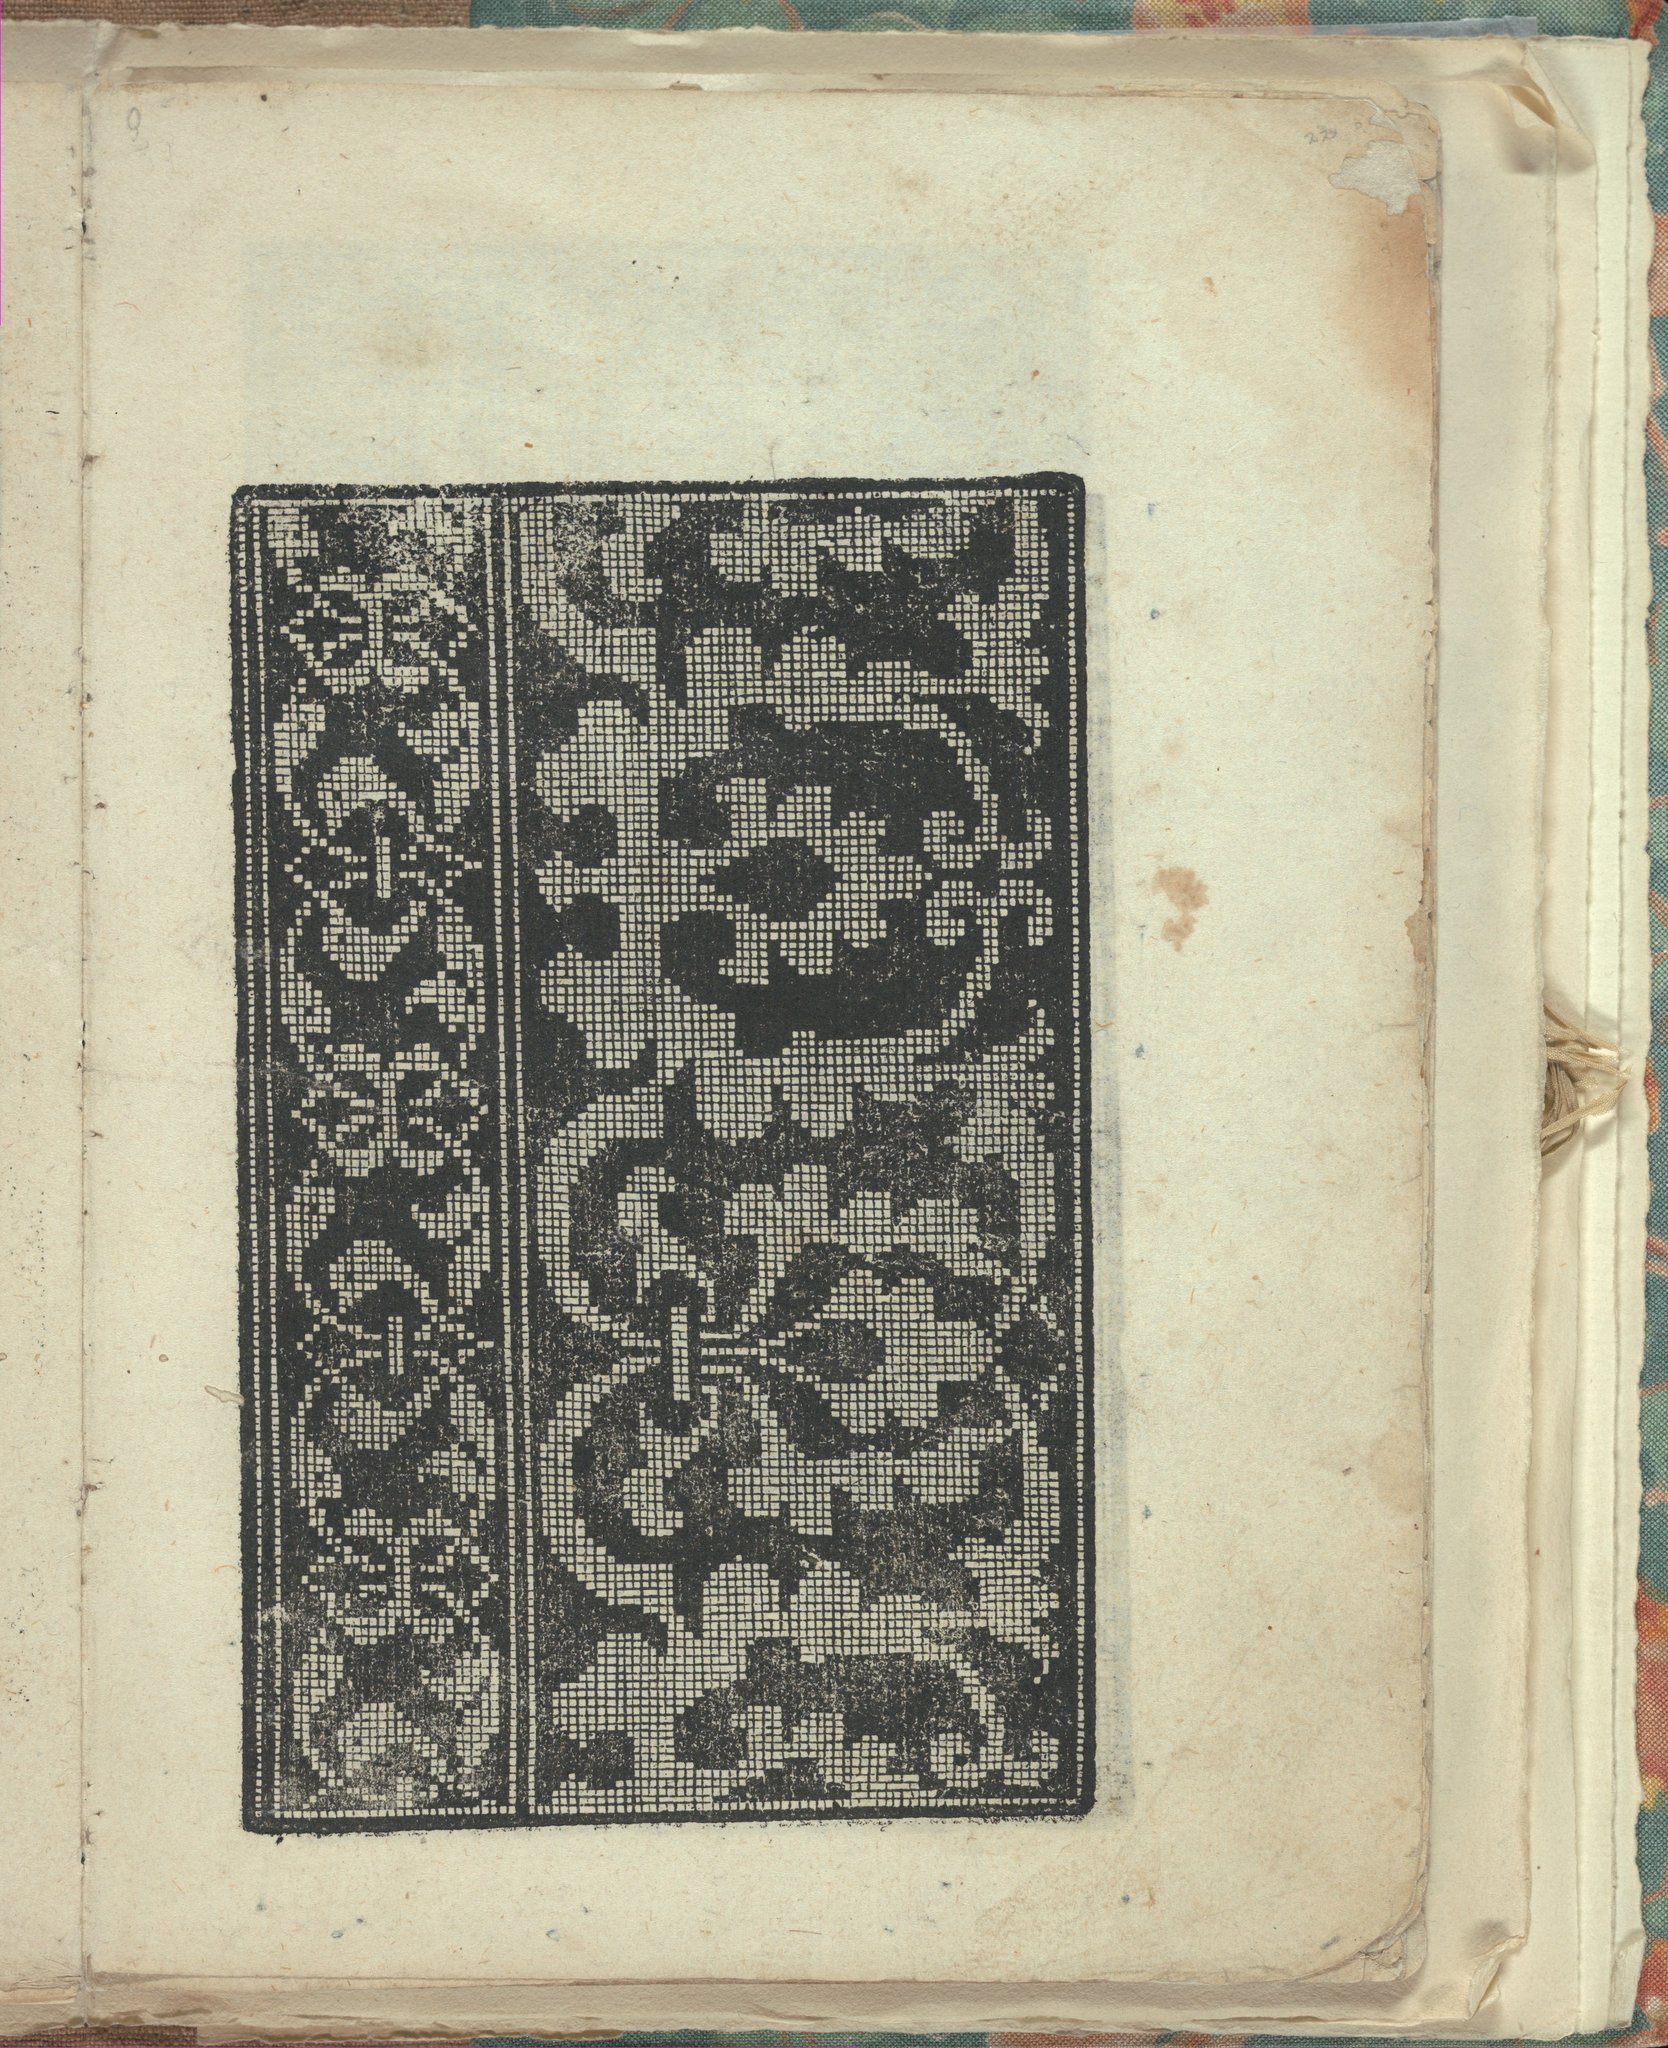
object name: book print ornament architecture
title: Opera Nova Universali intitulata Corona di racammi, page 22 (recto)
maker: giovanni andrea vavassore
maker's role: publisher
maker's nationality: italian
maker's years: 1530-1573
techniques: woodcut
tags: flowers